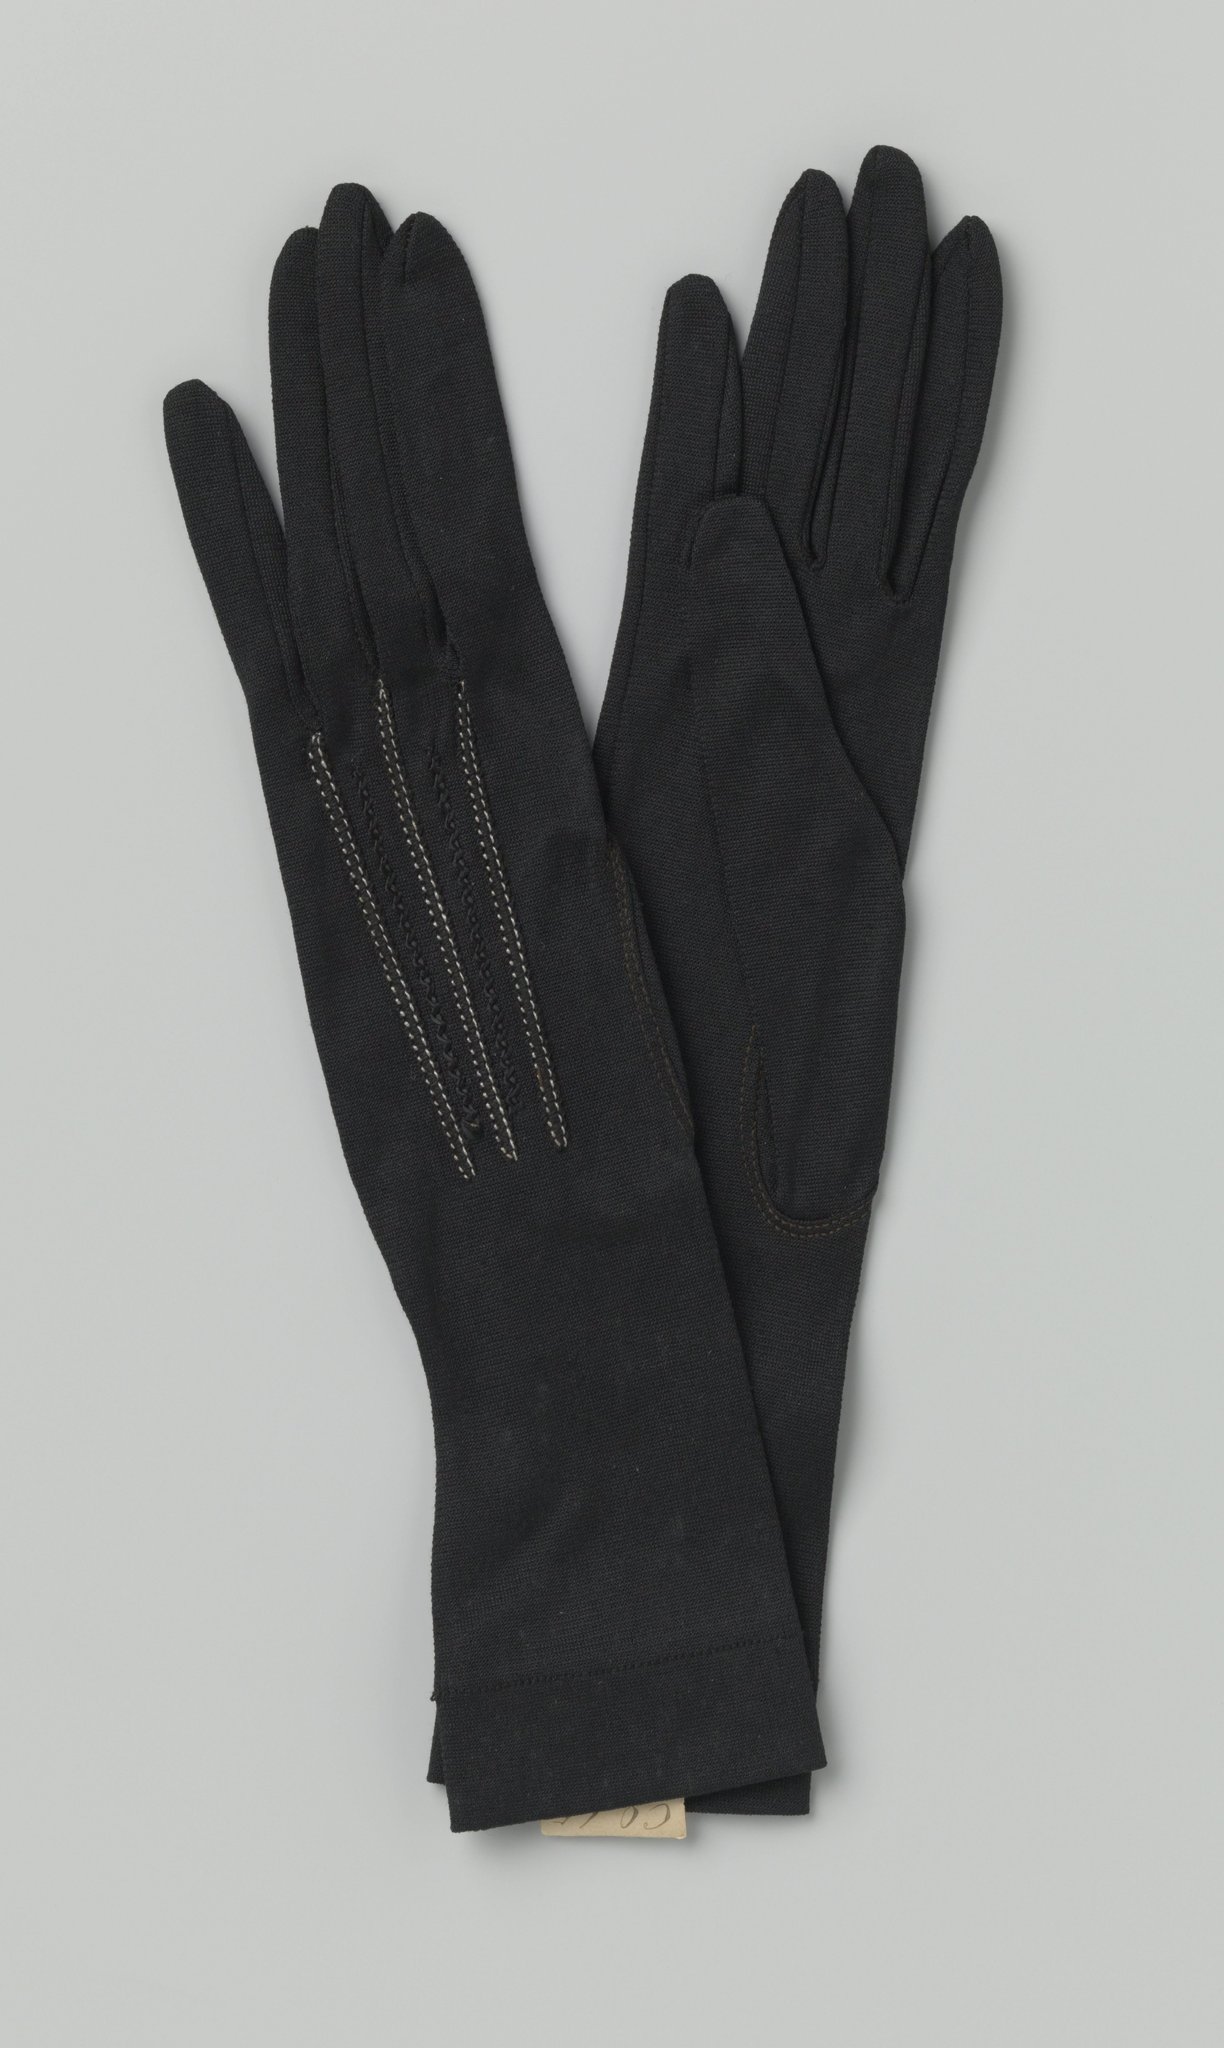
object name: glove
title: Pair of tricot gloves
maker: Anonymous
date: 1900-1910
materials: silk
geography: england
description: Linker handschoen van zwarte zijden triot. Op de rug vijf lijnen waarvan drie met wit doorgestikt. Bijeengebouden door een stuk karton en een draad. Waarschijnlijk ongedragen.